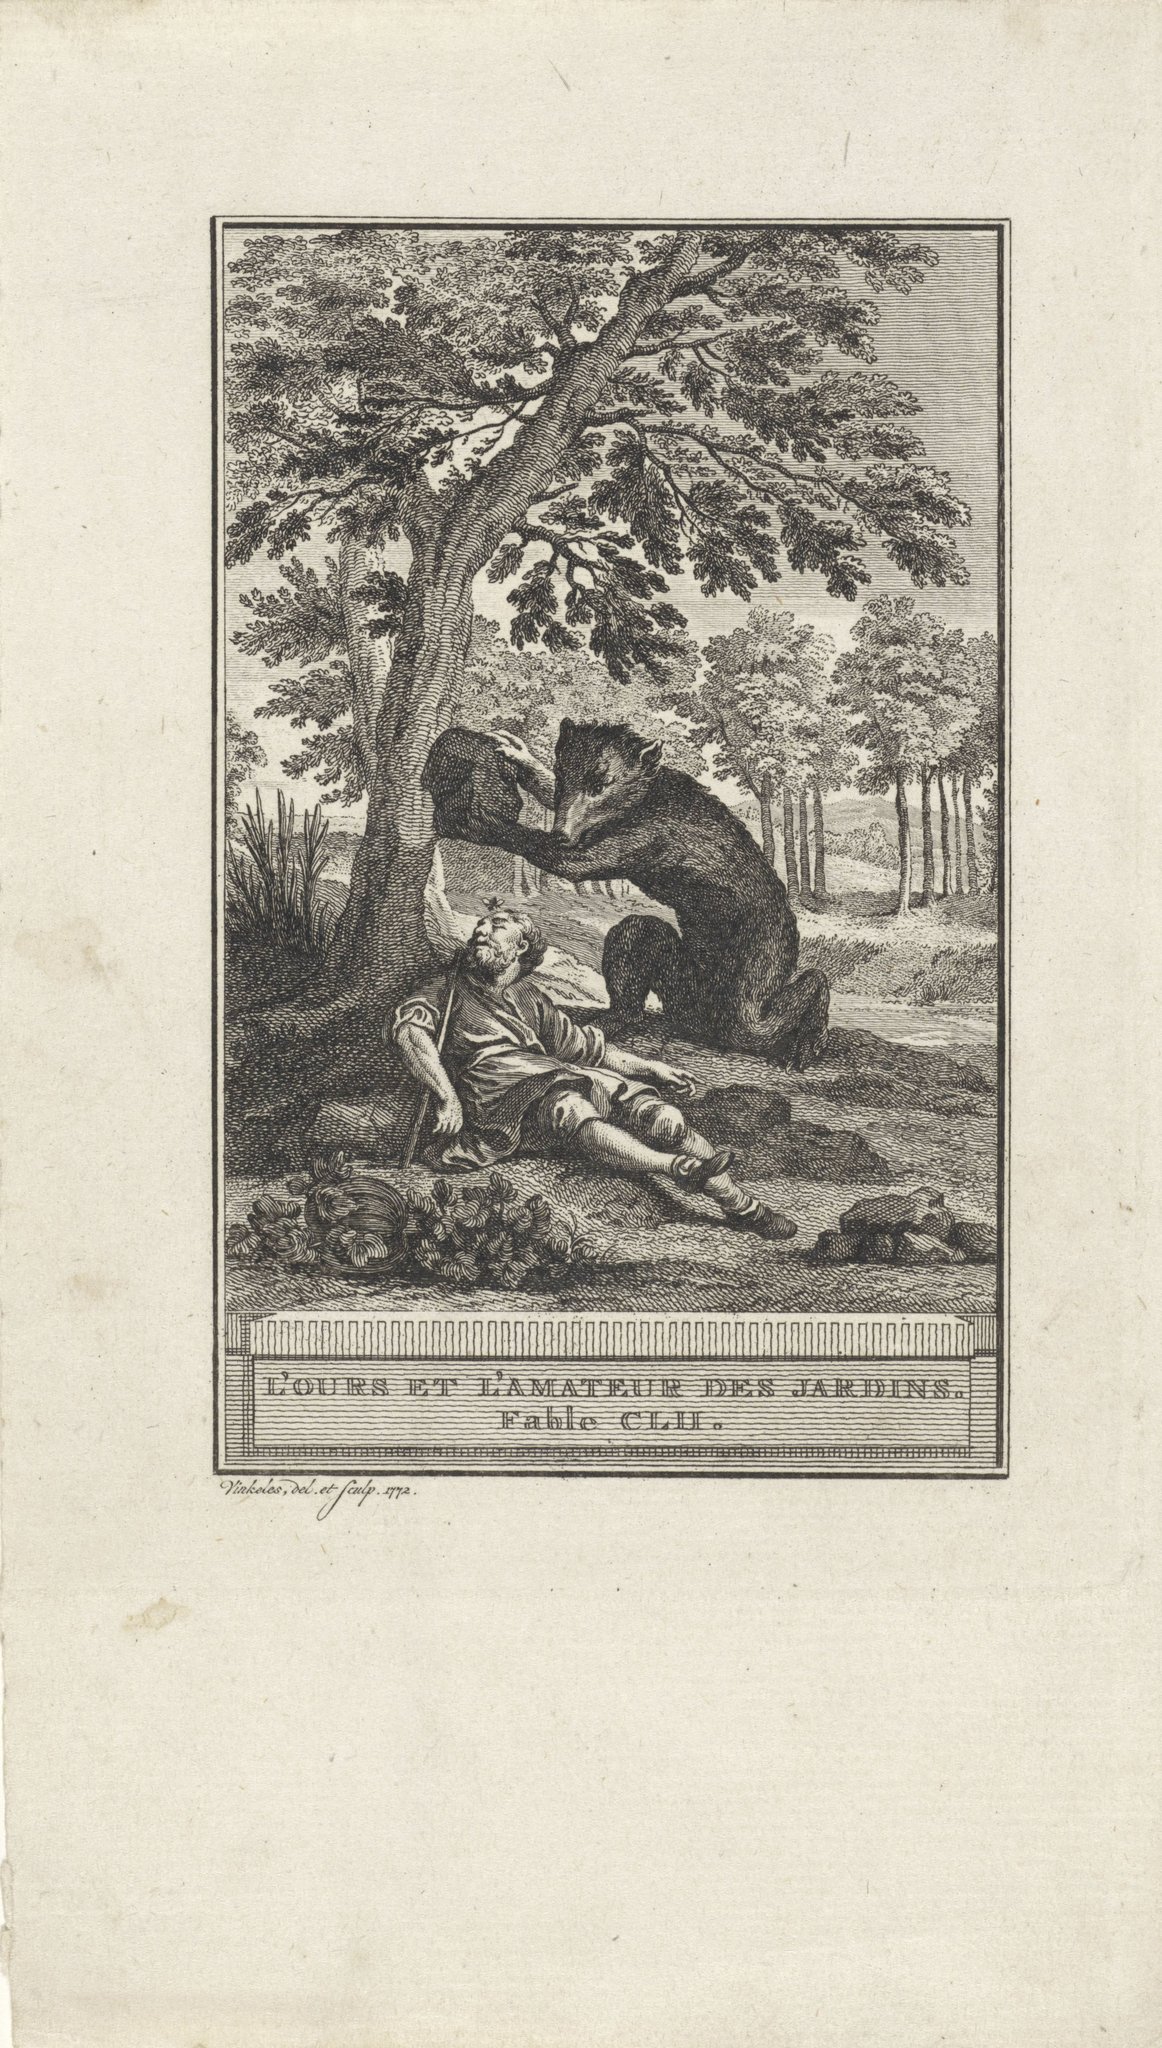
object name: print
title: L'Ours et L'Amateur des jardins. Fable CLII.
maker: reinier vinkeles (i)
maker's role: draughtsman, print maker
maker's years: 1741-1816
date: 1772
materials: paper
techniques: etching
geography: amsterdam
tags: sleeping on the ground - bb - out of doors, beasts of prey, predatory animals: bear, gardening, boulder, stone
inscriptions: collector's mark: Lugt 2228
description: Een beer staat op het punt om een grote kei op het hoofd van een slapende tuinman te laten vallen. Boven het hoofd van de tuinman vliegt een insect, mogelijk een bij. Illustratie van Fabel CLII, L'Ours et L'Amateur des jardins.